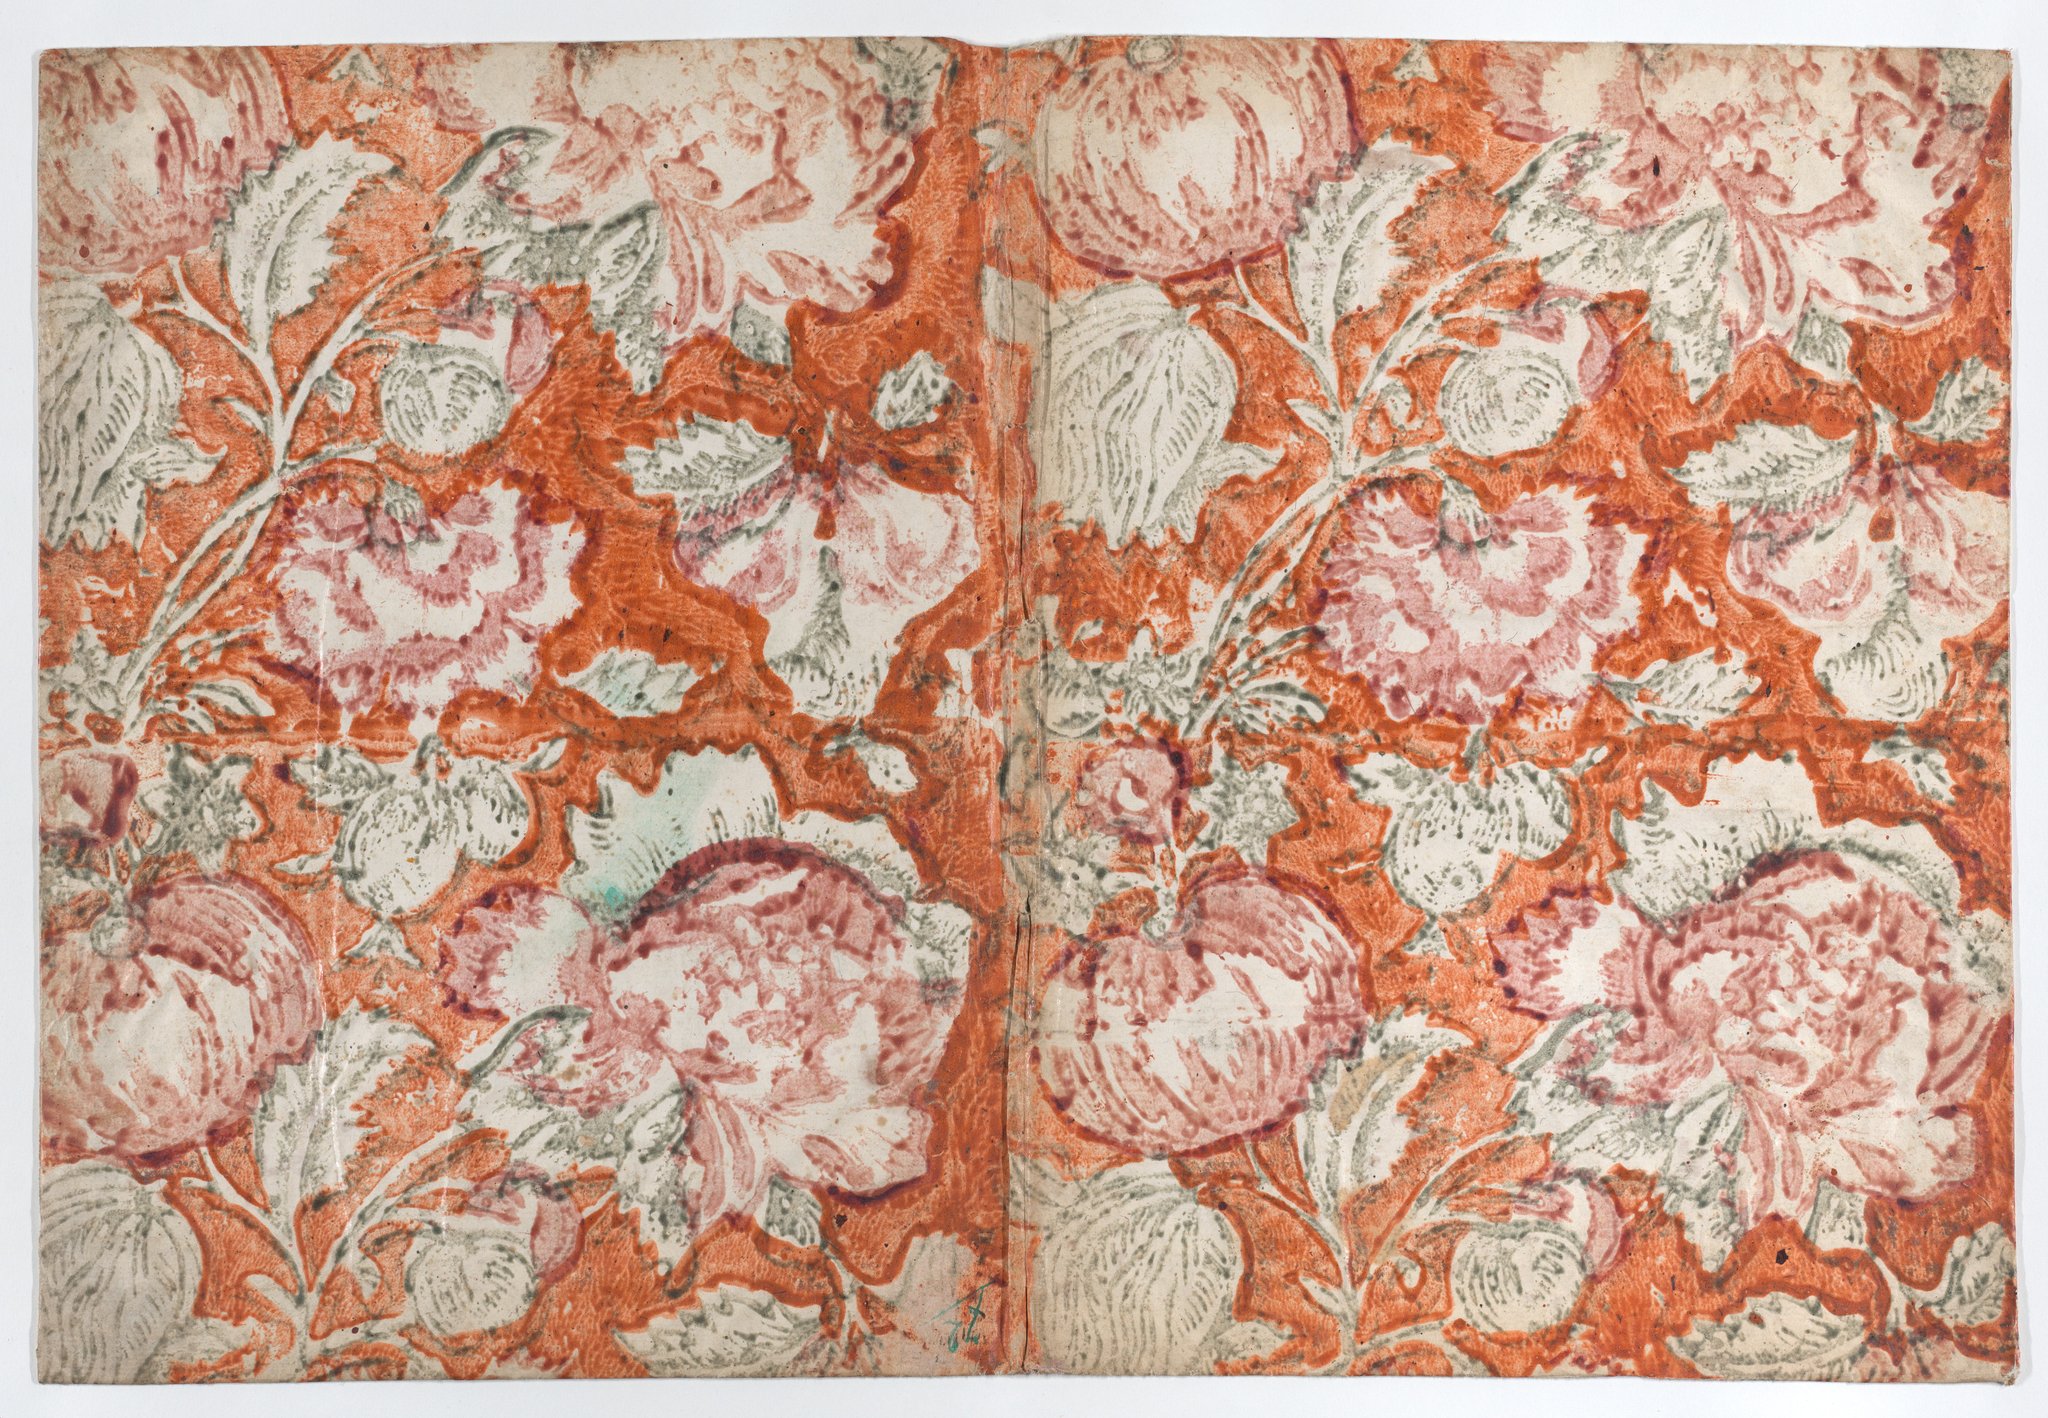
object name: print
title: Book cover with floral pattern with orange background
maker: Anonymous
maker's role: artist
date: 1701-1800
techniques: relief print